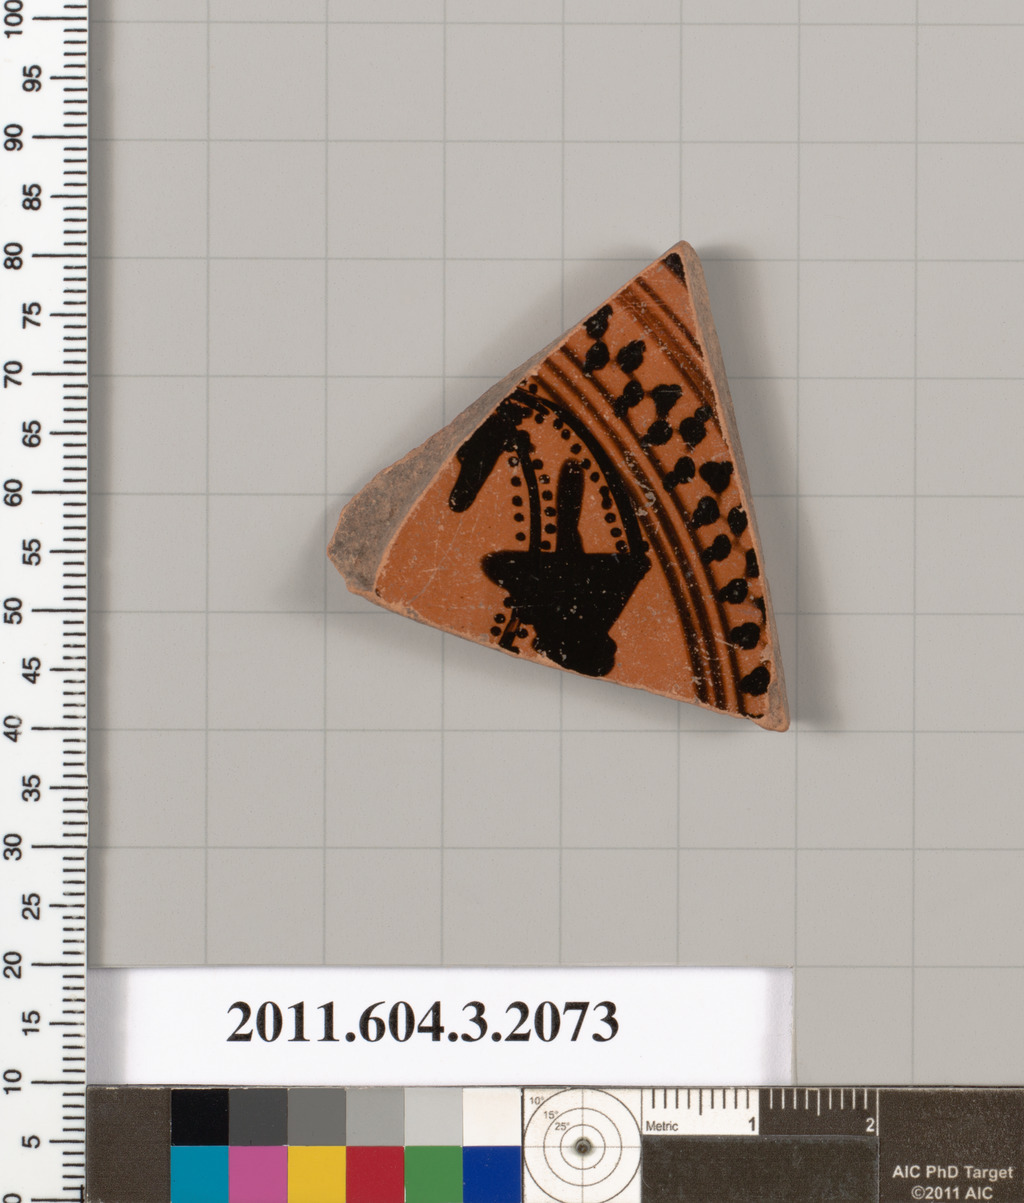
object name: kylix fragment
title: Terracotta fragment of a kylix (drinking cup)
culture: greek, attic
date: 525-501 BCE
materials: terracotta